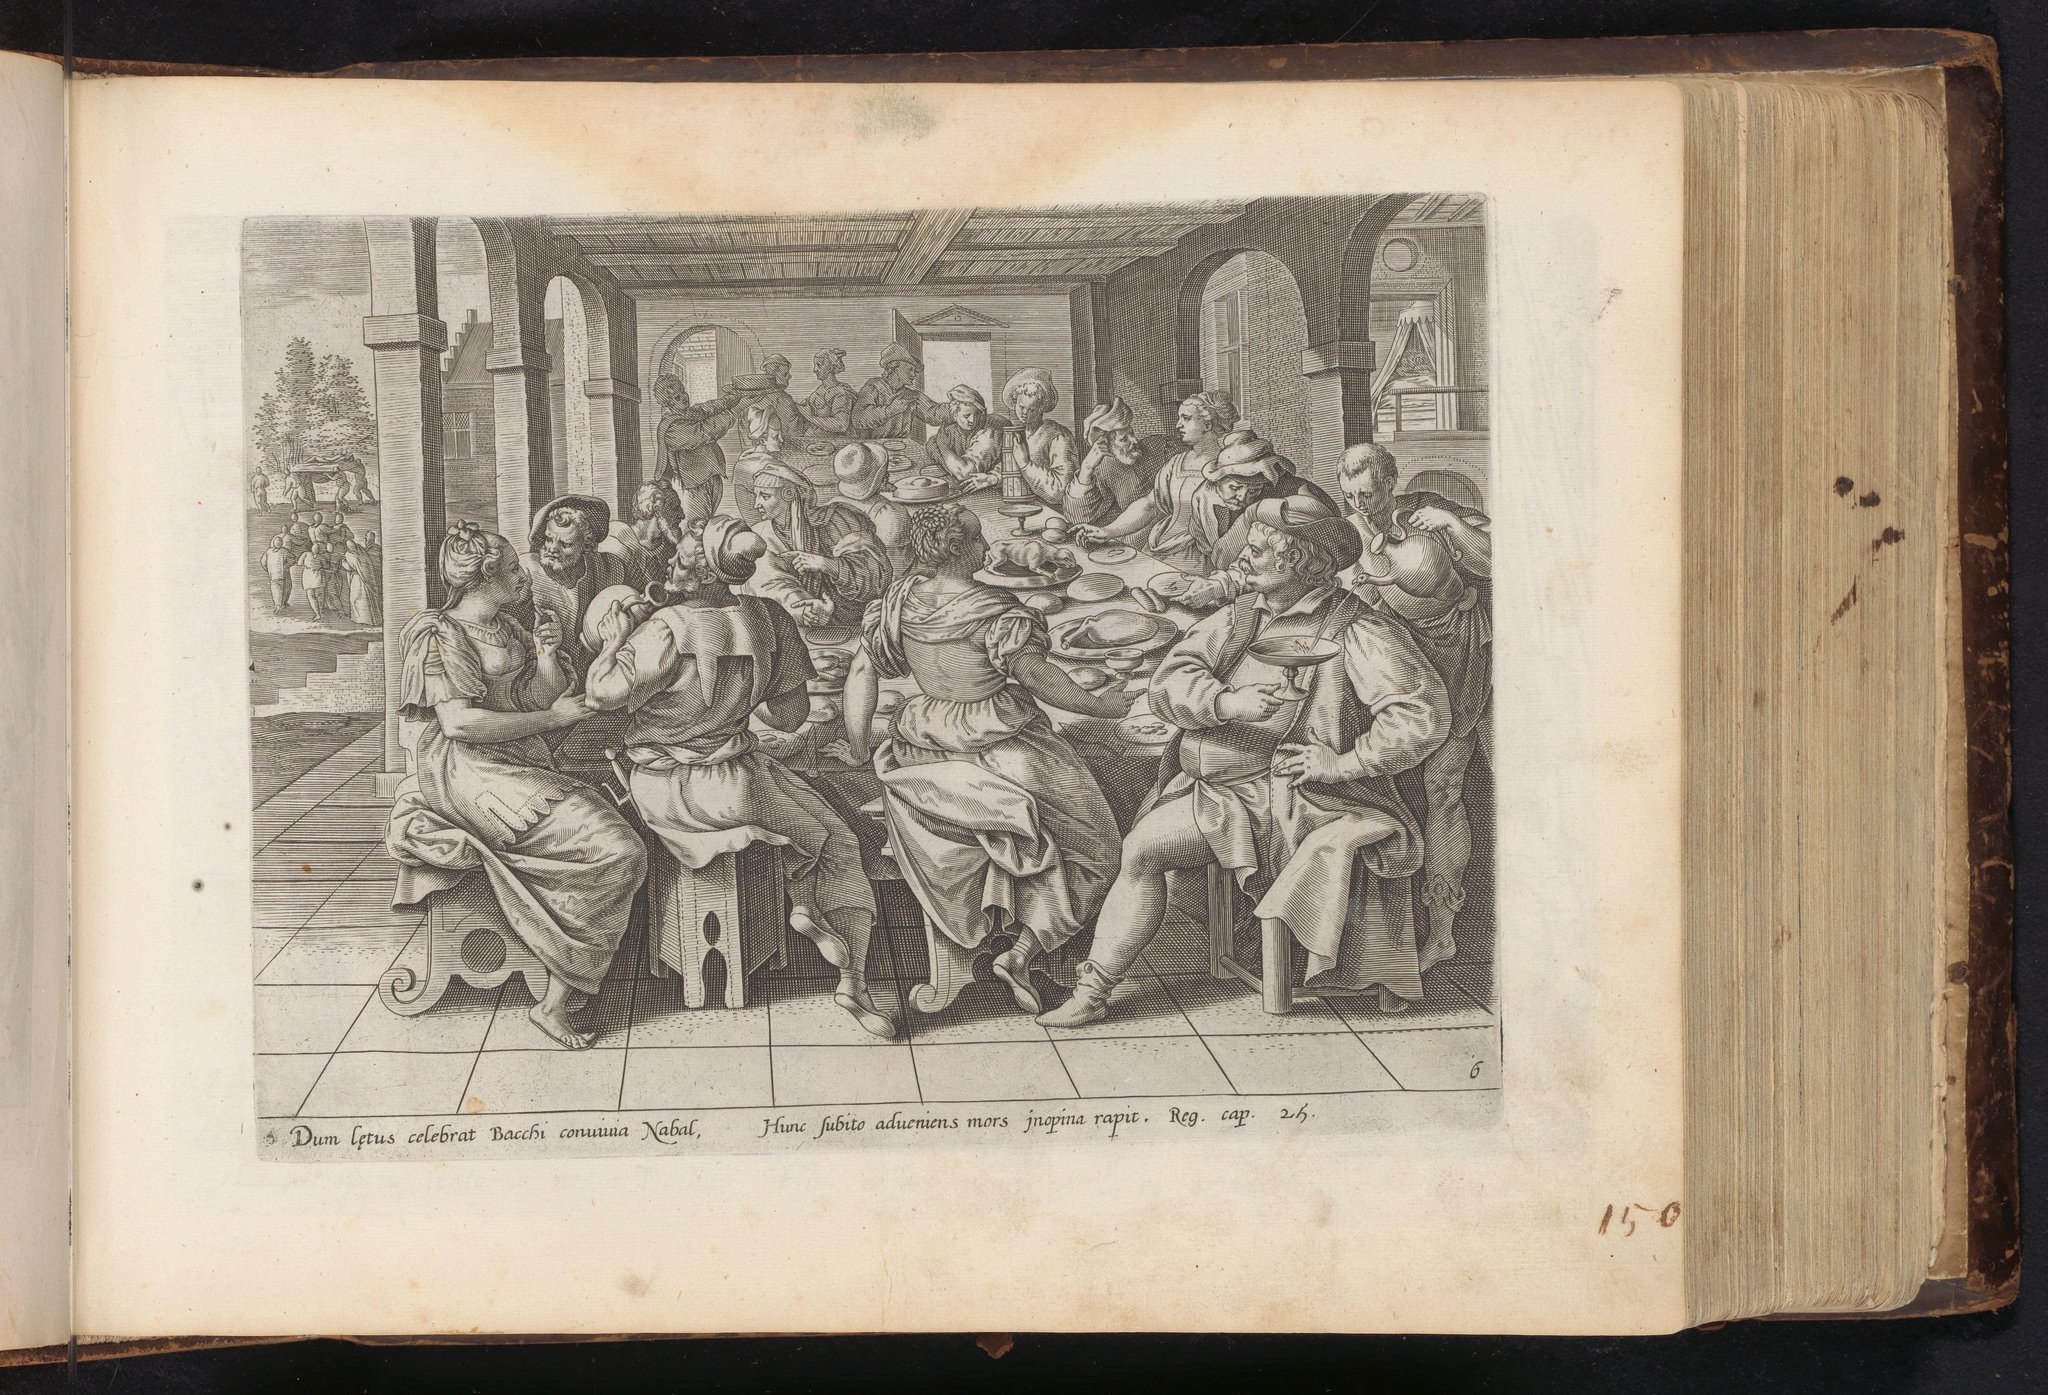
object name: print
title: Den Grooten Figuer-Bibel (...)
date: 1585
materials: paper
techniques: engraving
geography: amsterdam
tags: nabal dies, the banquet in nabal's house, celebration meal, feast, banquet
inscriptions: number: ‘150’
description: Nabal en Abigaïl zitten aan Nabals feestmaal en Nabal laat zich nog eens inschenken. Rechts op de achtergrond het bed van Nabal en Abigaïl. Nadat Nabal zijn roes had uitgeslapen vertelde Abigaïl wat ze had gedaan. Op die mededeling stierf Nabal. Links op de achtergrond de rouwstoet, waarmee het lichaam van Nabal wordt weggedragen. Onder de voorstelling een verwijzing in het Latijn naar de Bijbeltekst in 1 Sam. 25. Deze prent maakt deel uit van een album.